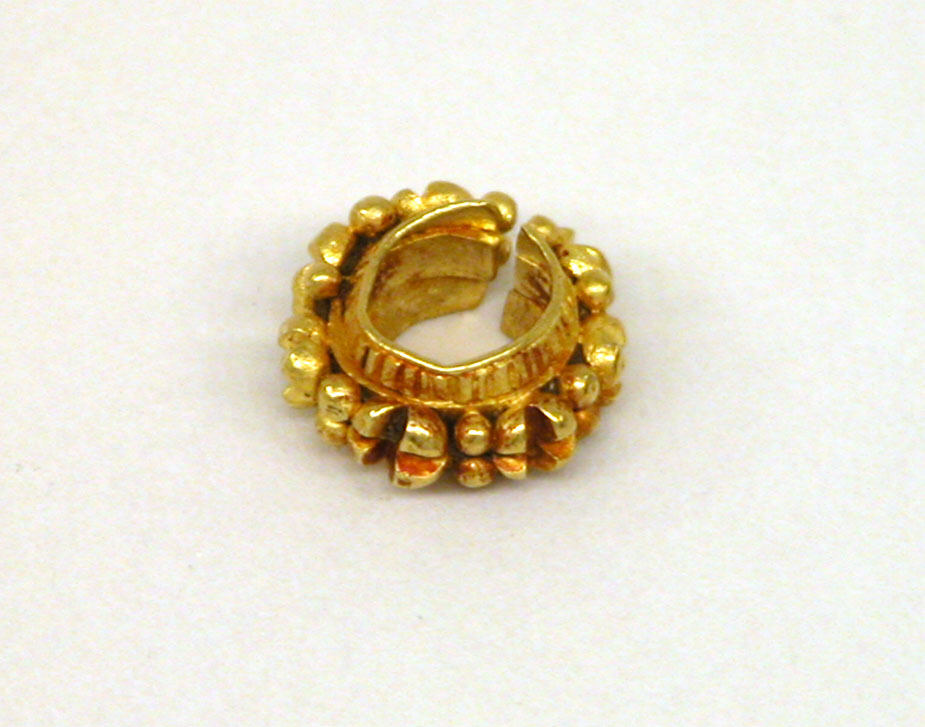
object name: ear ornament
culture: indonesian, javanese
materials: gold